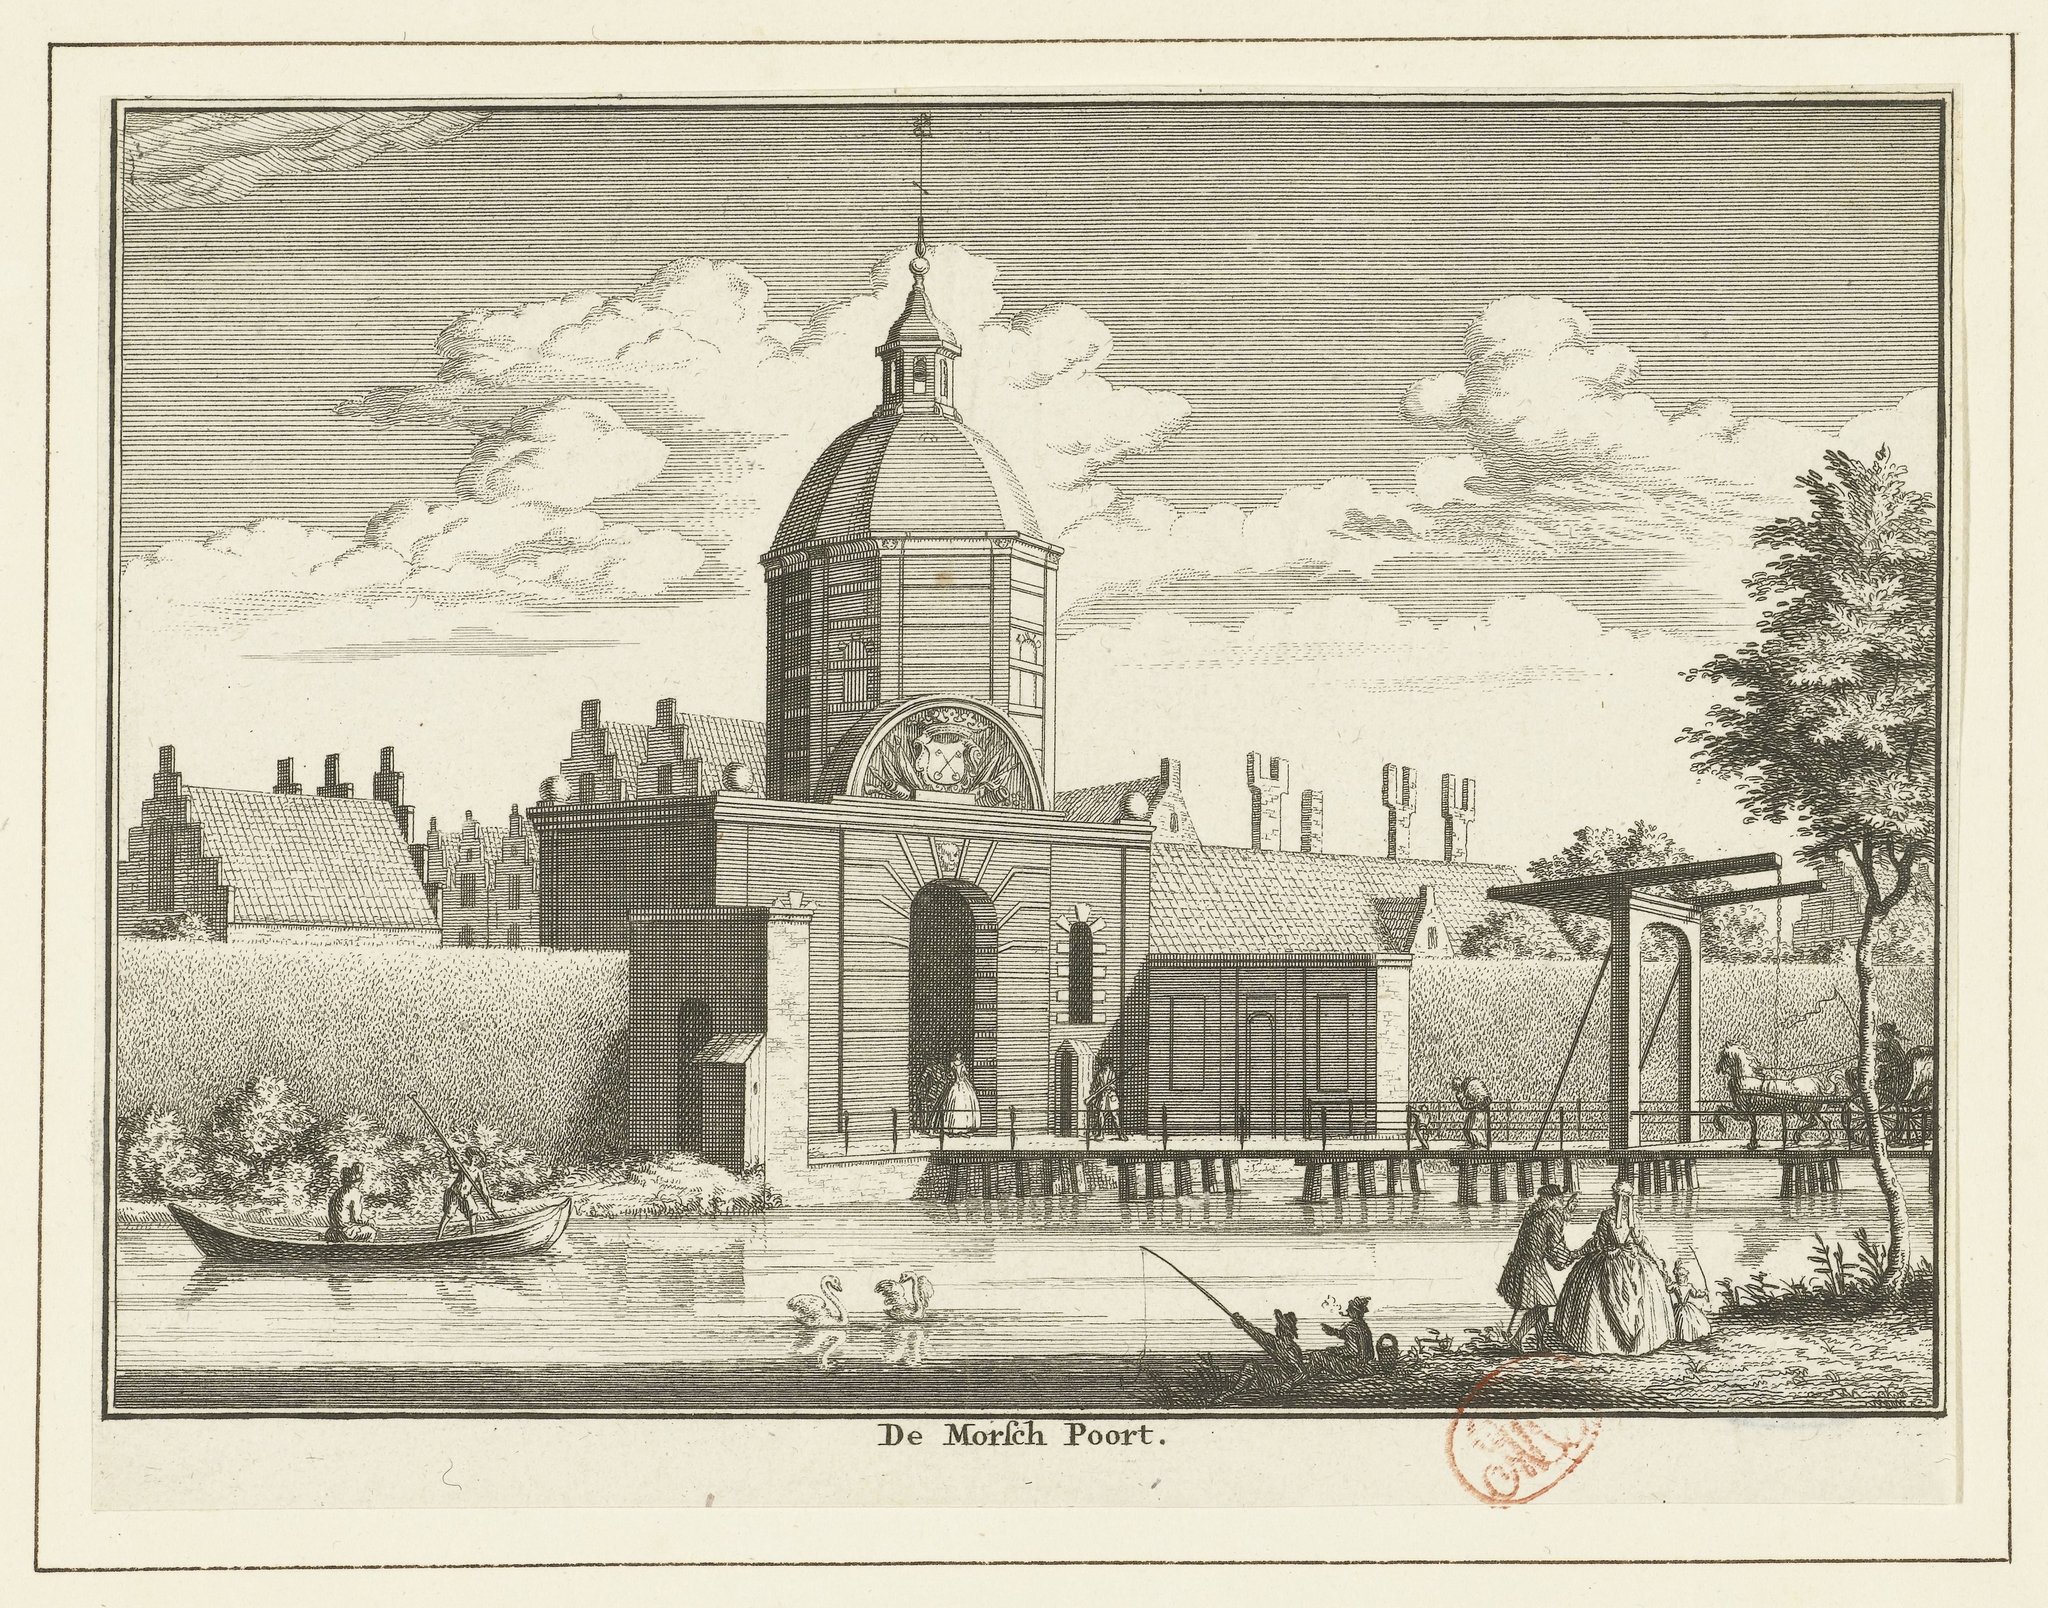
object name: print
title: Gezicht op de Morspoort te Leiden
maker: andries van buysen (sr.)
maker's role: print maker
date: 1734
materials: paper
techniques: engraving, etching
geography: amsterdam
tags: bridge, city-gate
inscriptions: collector's mark: Lugt 2228, collector's mark: Lugt 195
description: Prent ook gebruikt in: De vermakelyke Leidsche buiten-cingels, aangenaame dorpen en landstreken, rondom die stad gelegen (…) versiert met alle de stadts-poorten. Leiden: Quirinum Visscher, Amsterdam: Arent van Huyssteen, 1734.